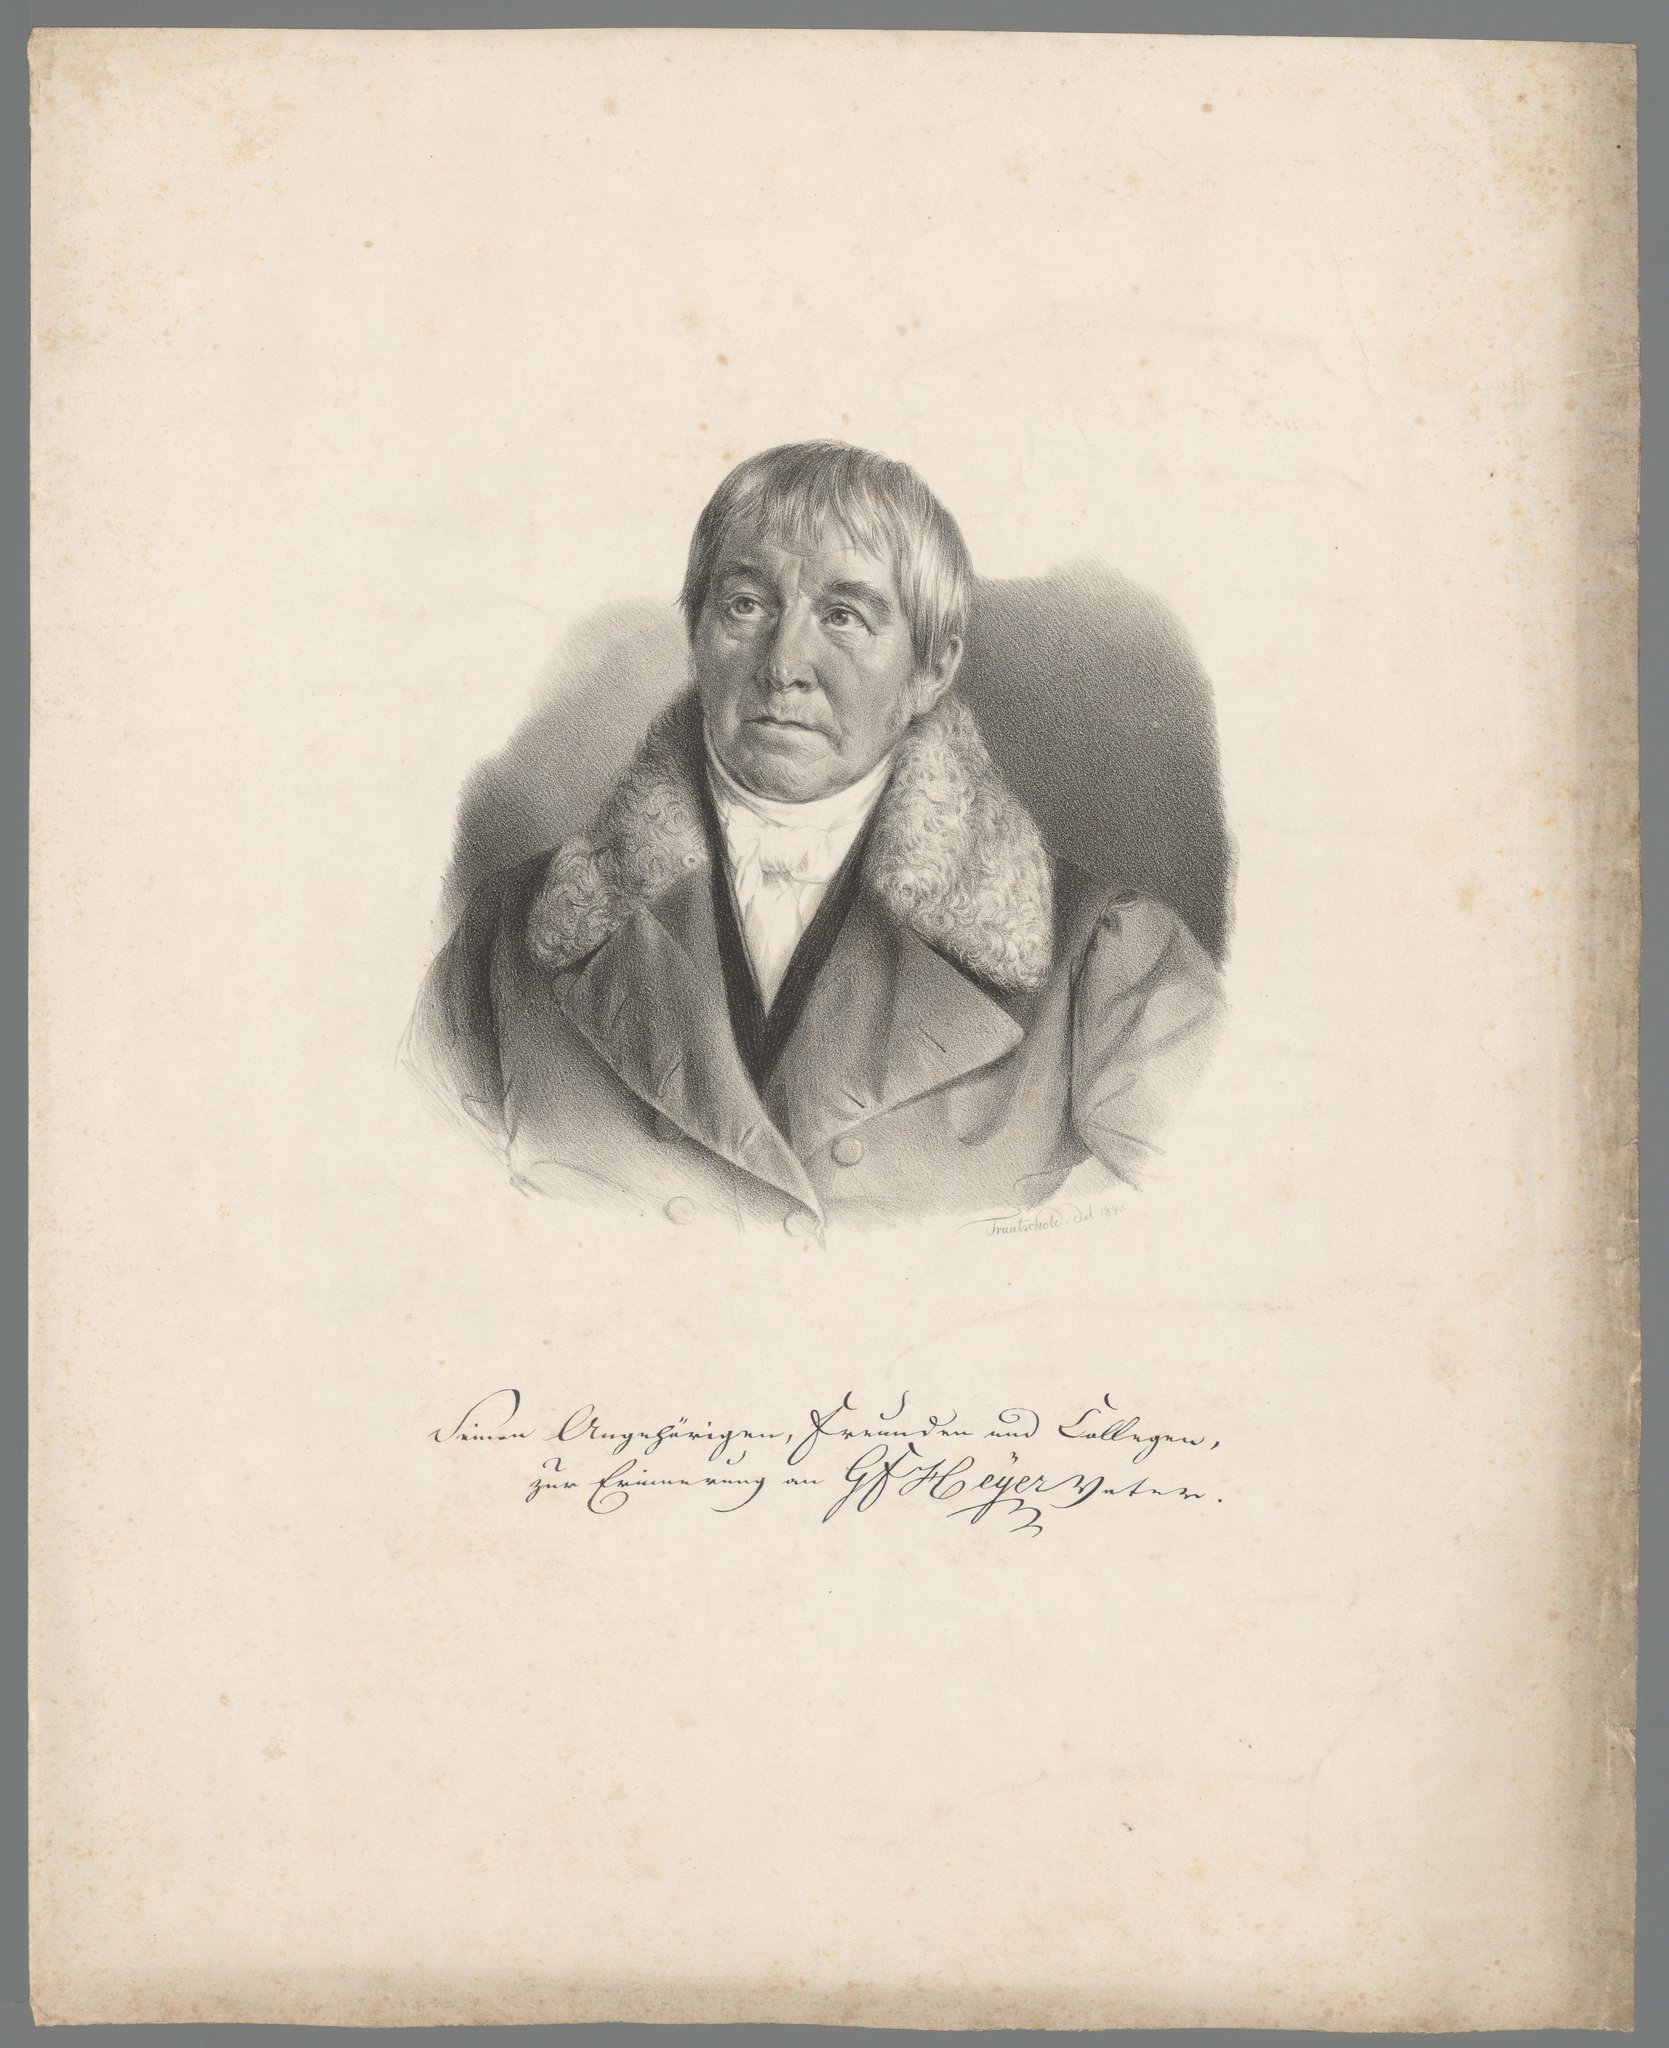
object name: print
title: Portret van Georg Friedrich Heyer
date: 1841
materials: paper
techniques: lithograph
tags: historical persons, old man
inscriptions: collector's mark: Lugt 2228